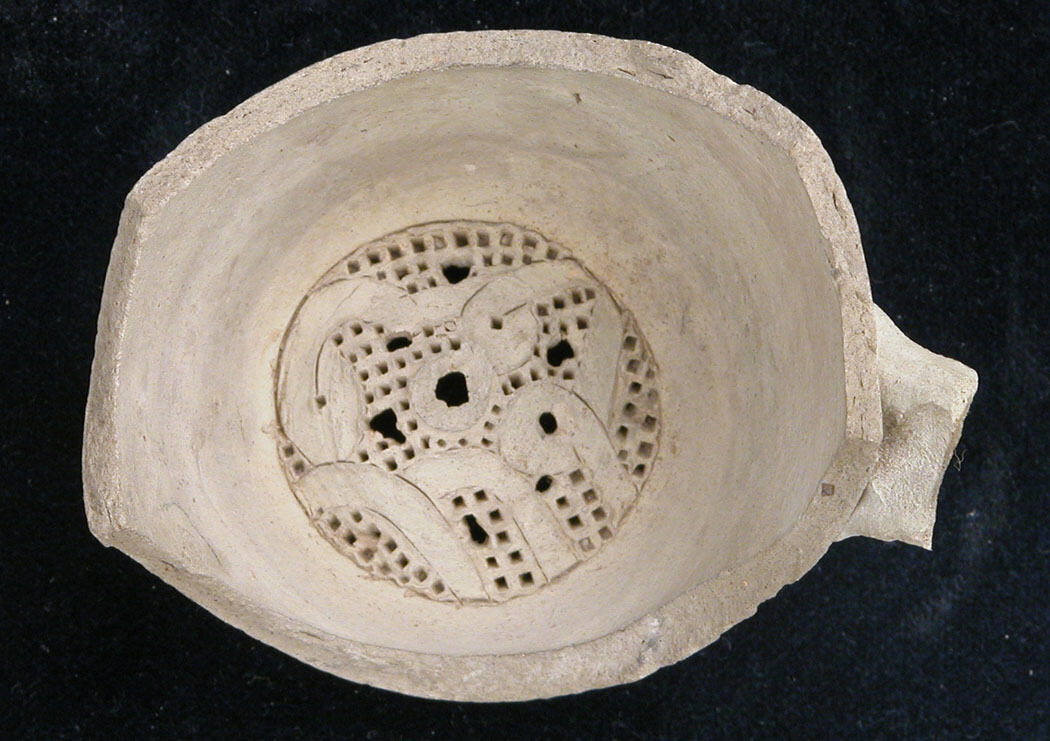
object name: water filter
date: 901-1200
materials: earthenware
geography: egypt